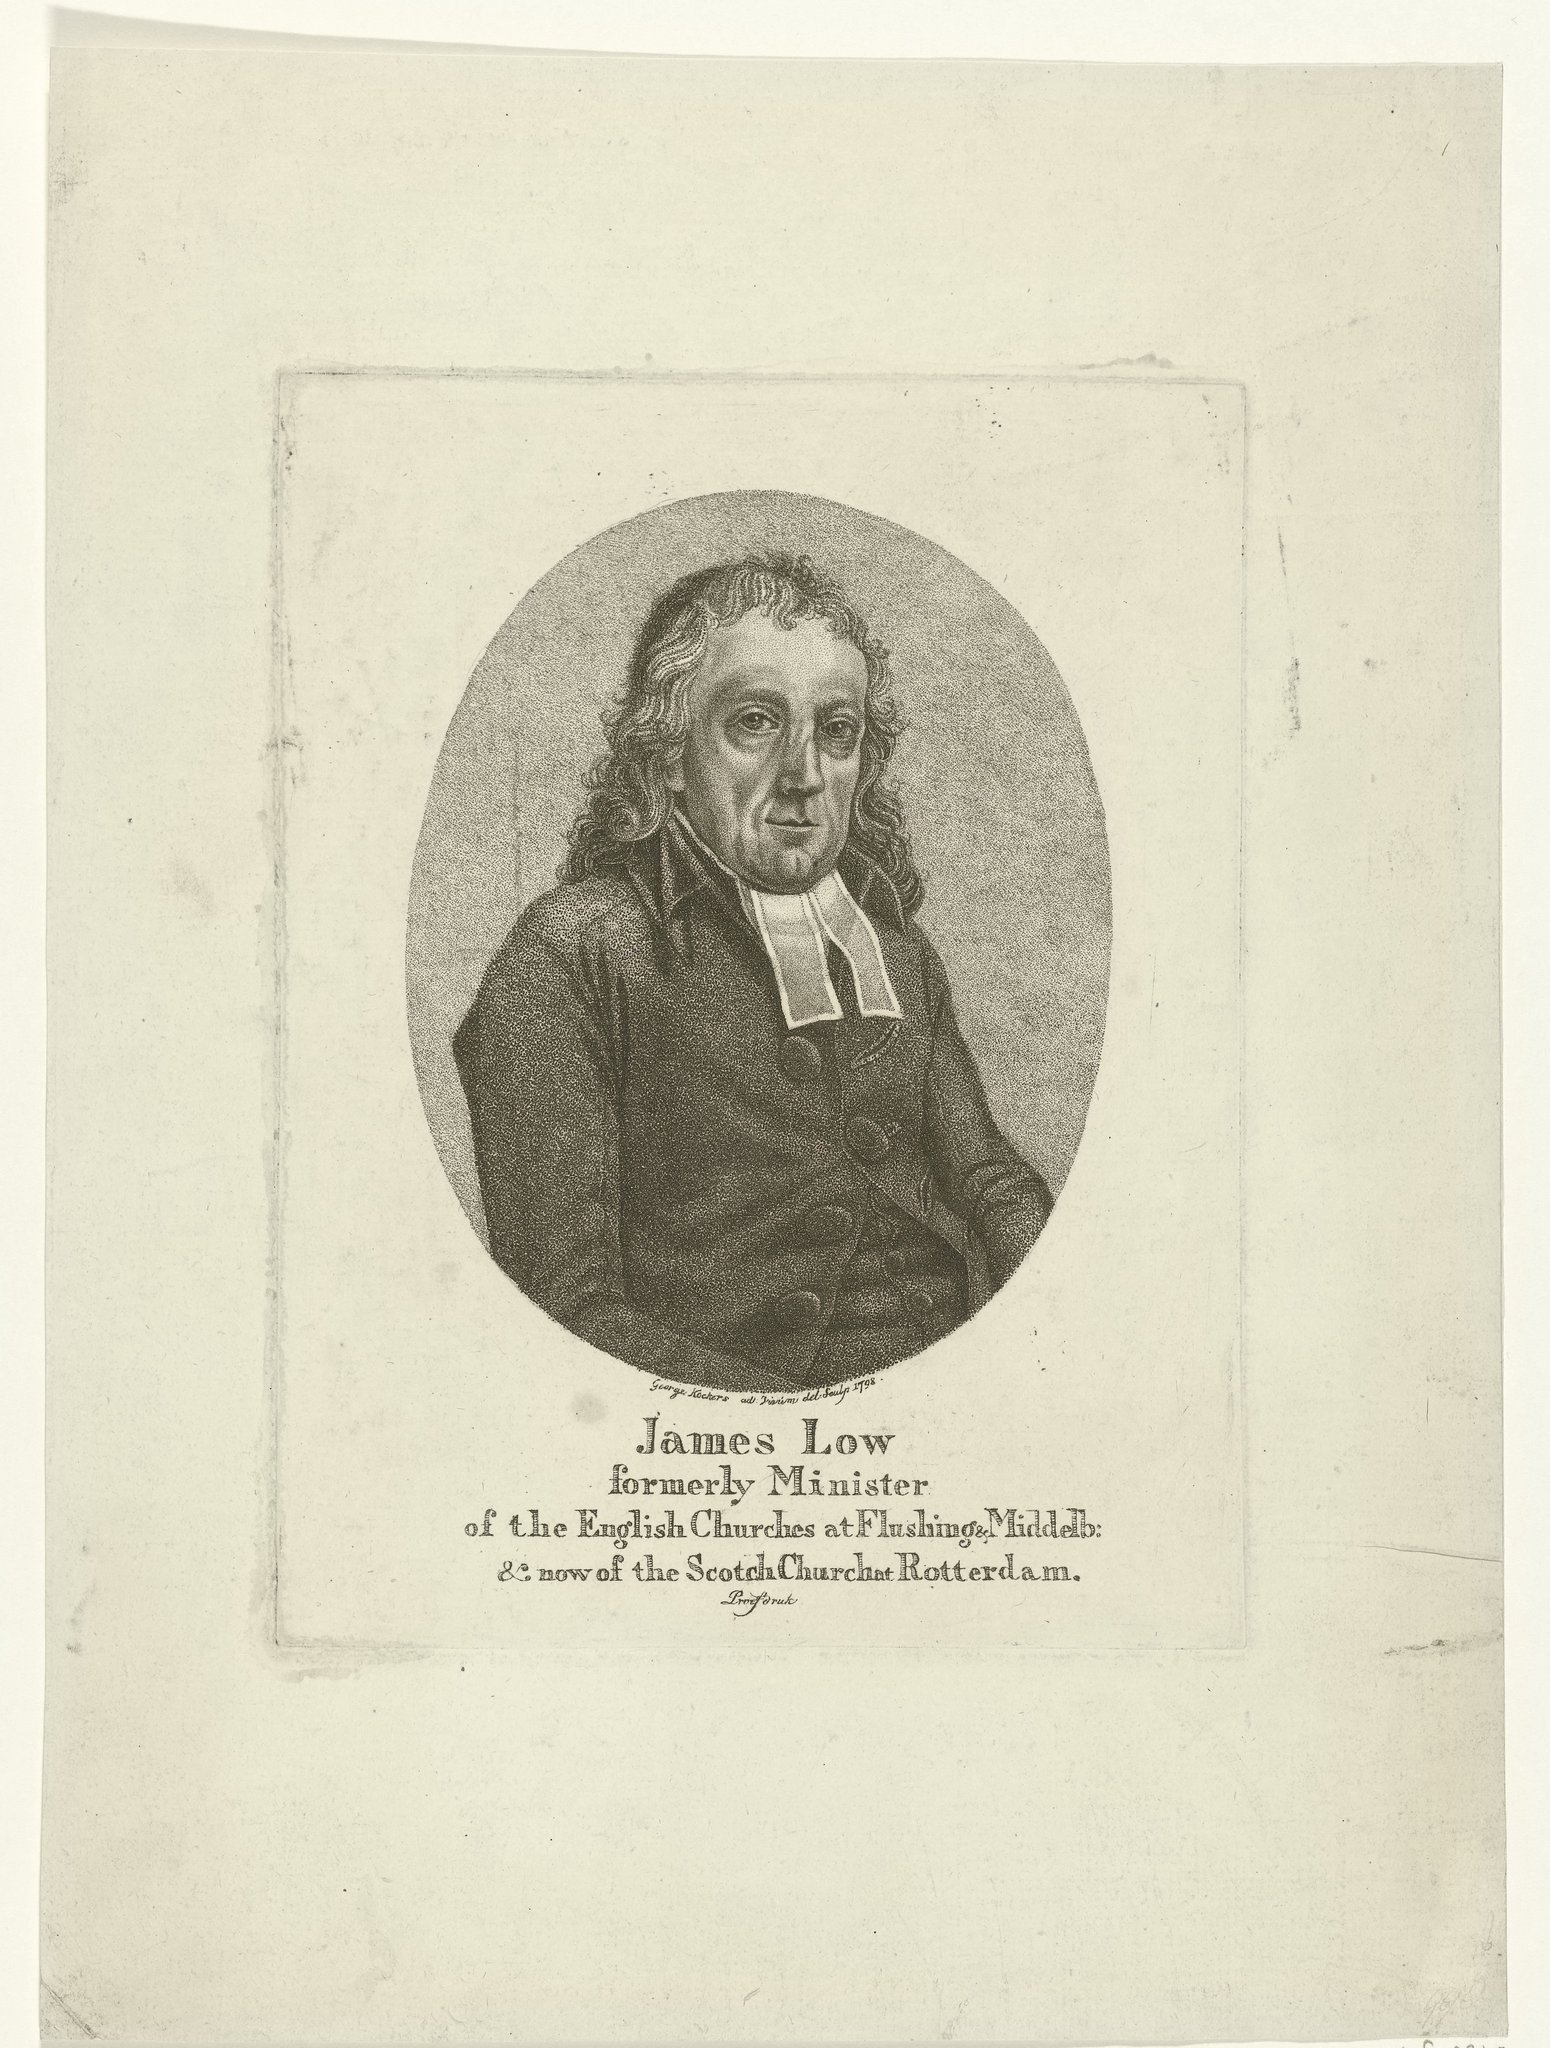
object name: print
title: Portret van James Low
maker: george kockers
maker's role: goldsmith, print maker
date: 1798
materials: paper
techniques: etching, engraving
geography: middelburg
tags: rotterdam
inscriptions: collector's mark: Lugt 2228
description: Portret ten halven lijve naar rechts in een ovaal van de Engelsman James Low, predikant in onder andere Vlissingen, Middelburg en Rotterdam. Low is gekleed in ambtsgewaad en draagt een bef.